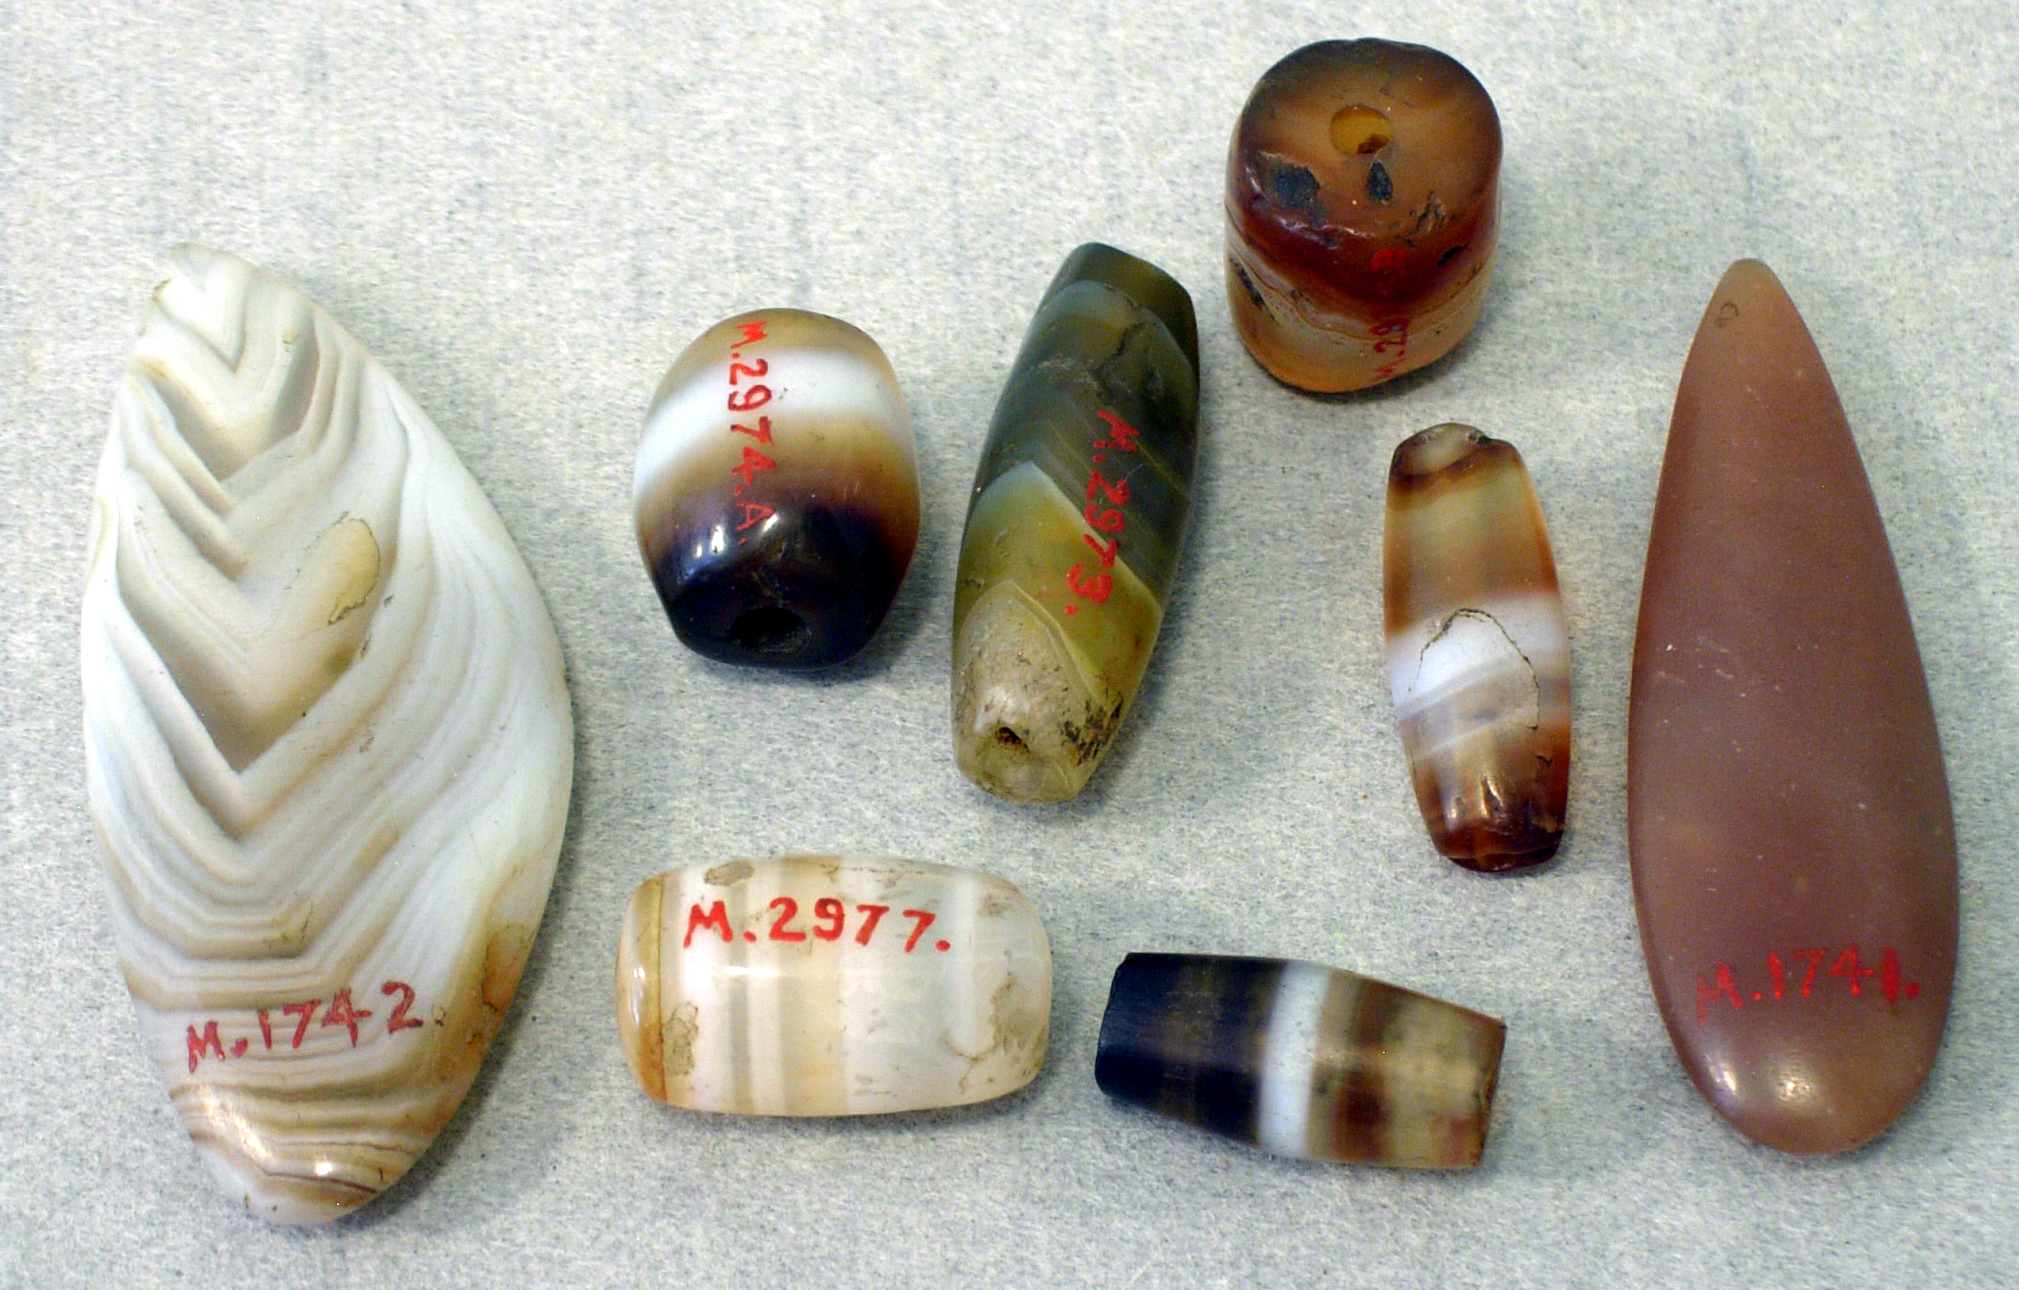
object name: bead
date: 801-1900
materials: stone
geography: egypt